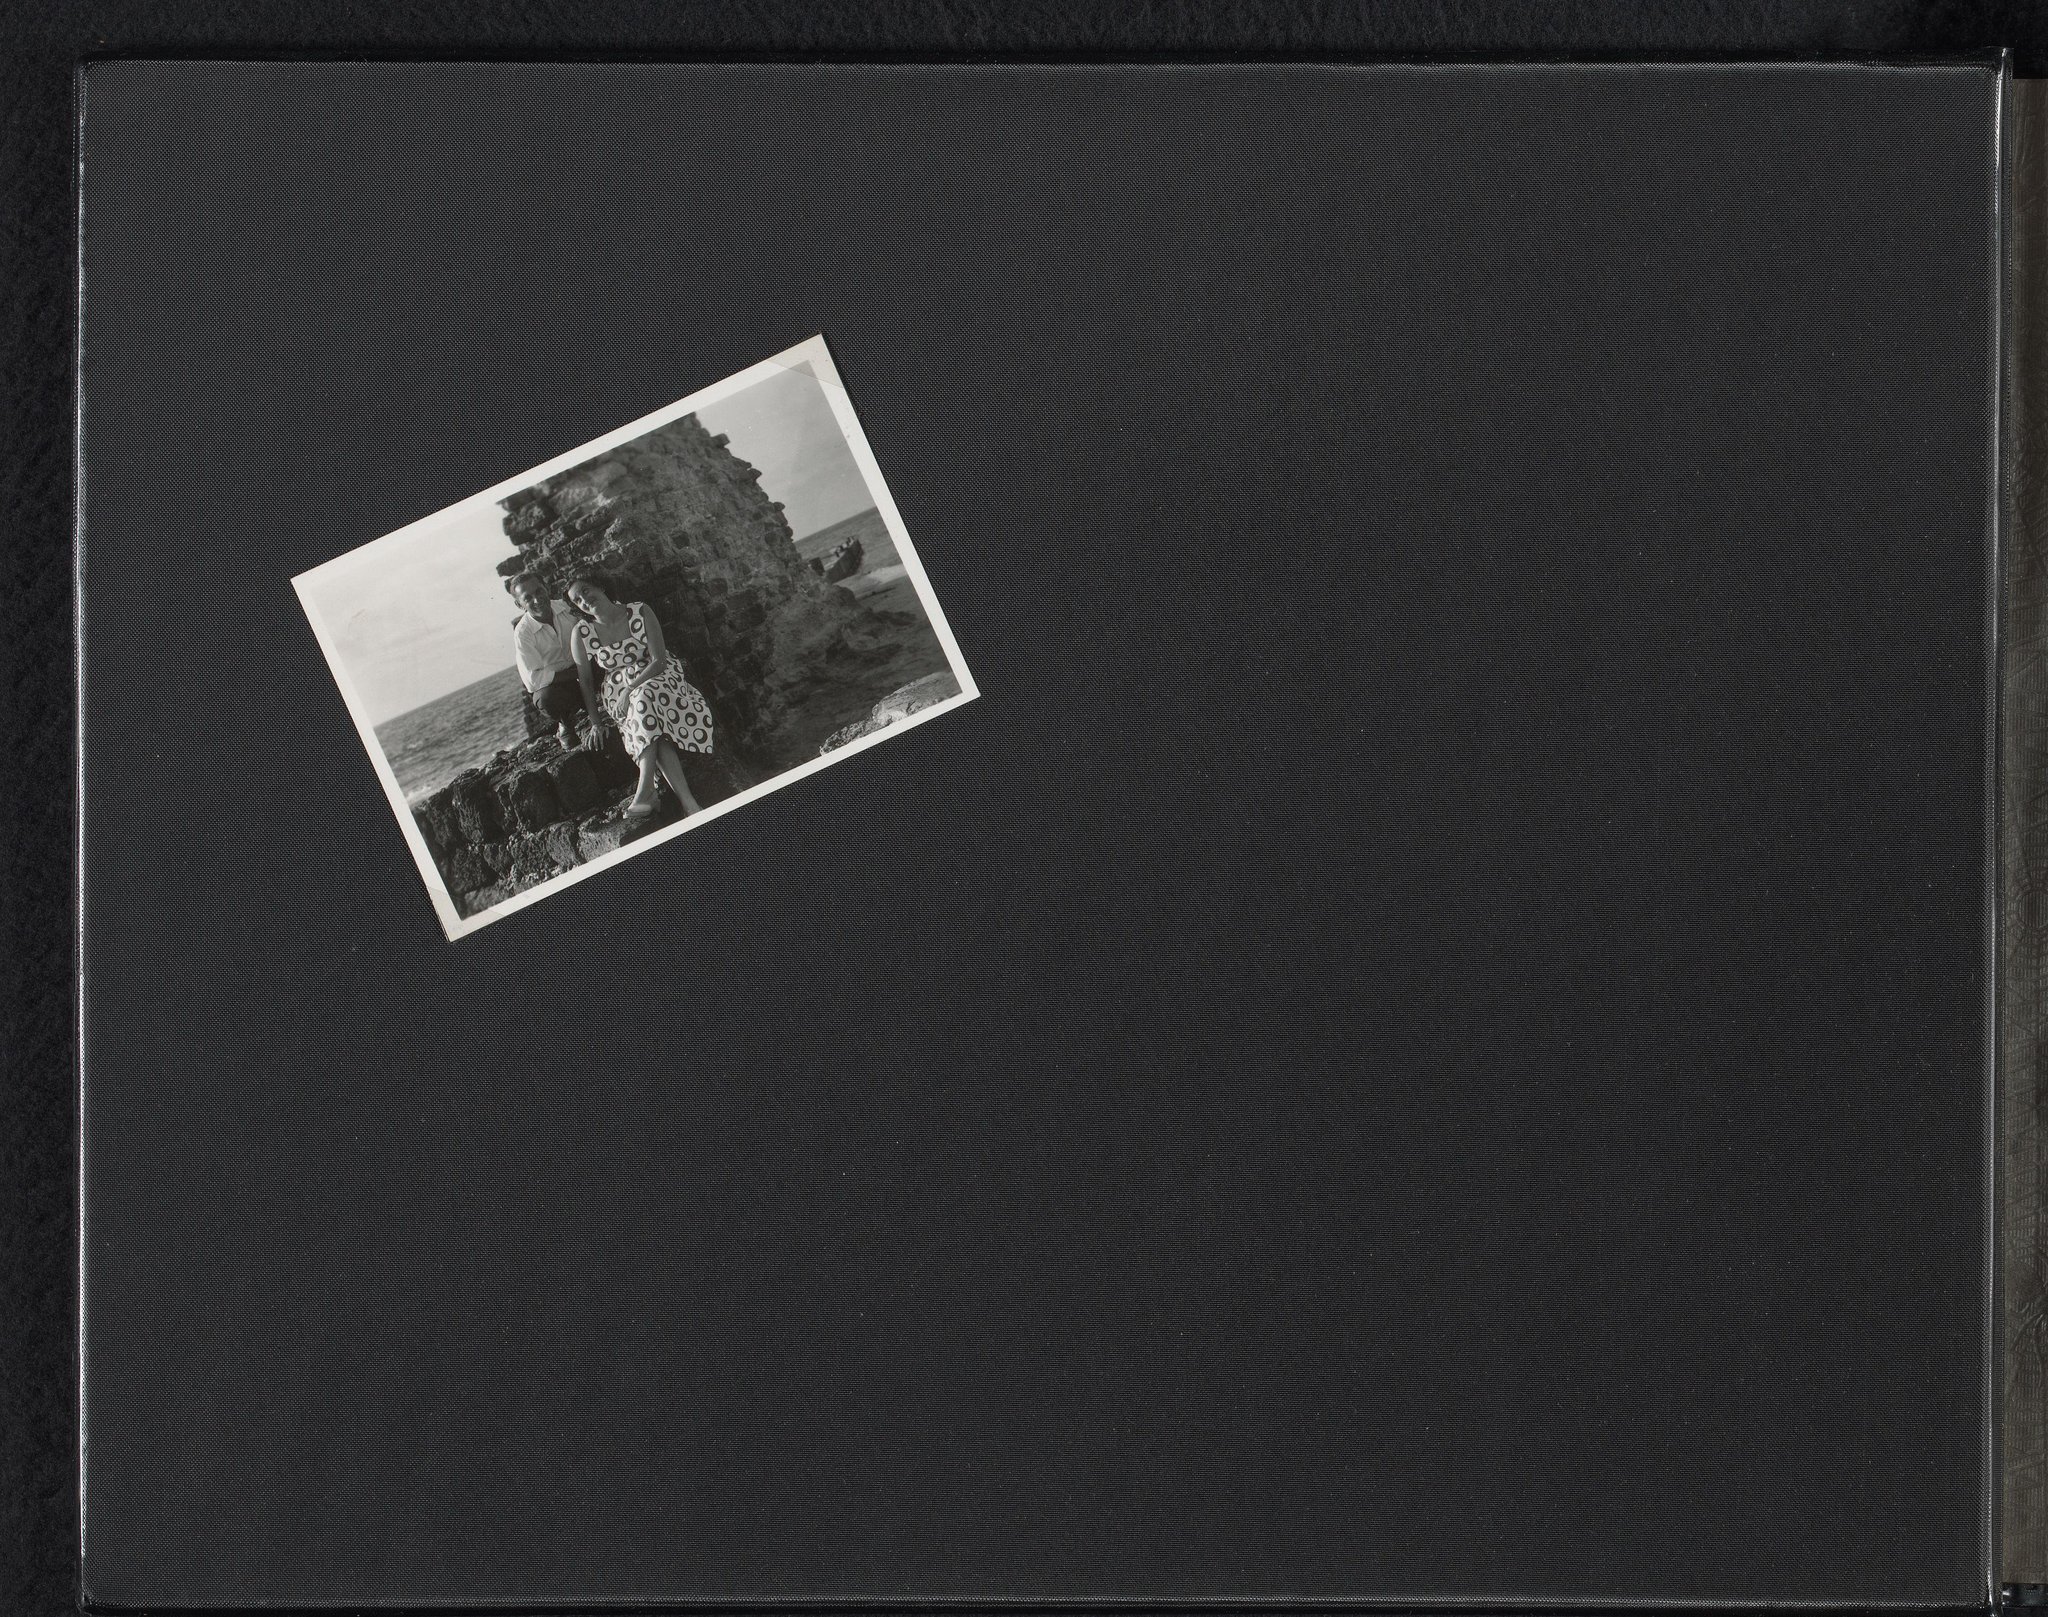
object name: photograph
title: Portret van Isabel Wachenheimer en haar derde echtgenoot Gideon Elon op huwelijksreis aan de kust, omgeving Middellandse Zee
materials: paper, plastic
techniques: gelatin silver print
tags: isabel wachenheimer-elon, gideon elon, wedding trip, honeymoon, historical person in a double portrait, coast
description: Blad bevat een foto van Gideon Elon (links) en Isabel Wachenheimer (rechts). Deze foto's maken deel uit van een album.